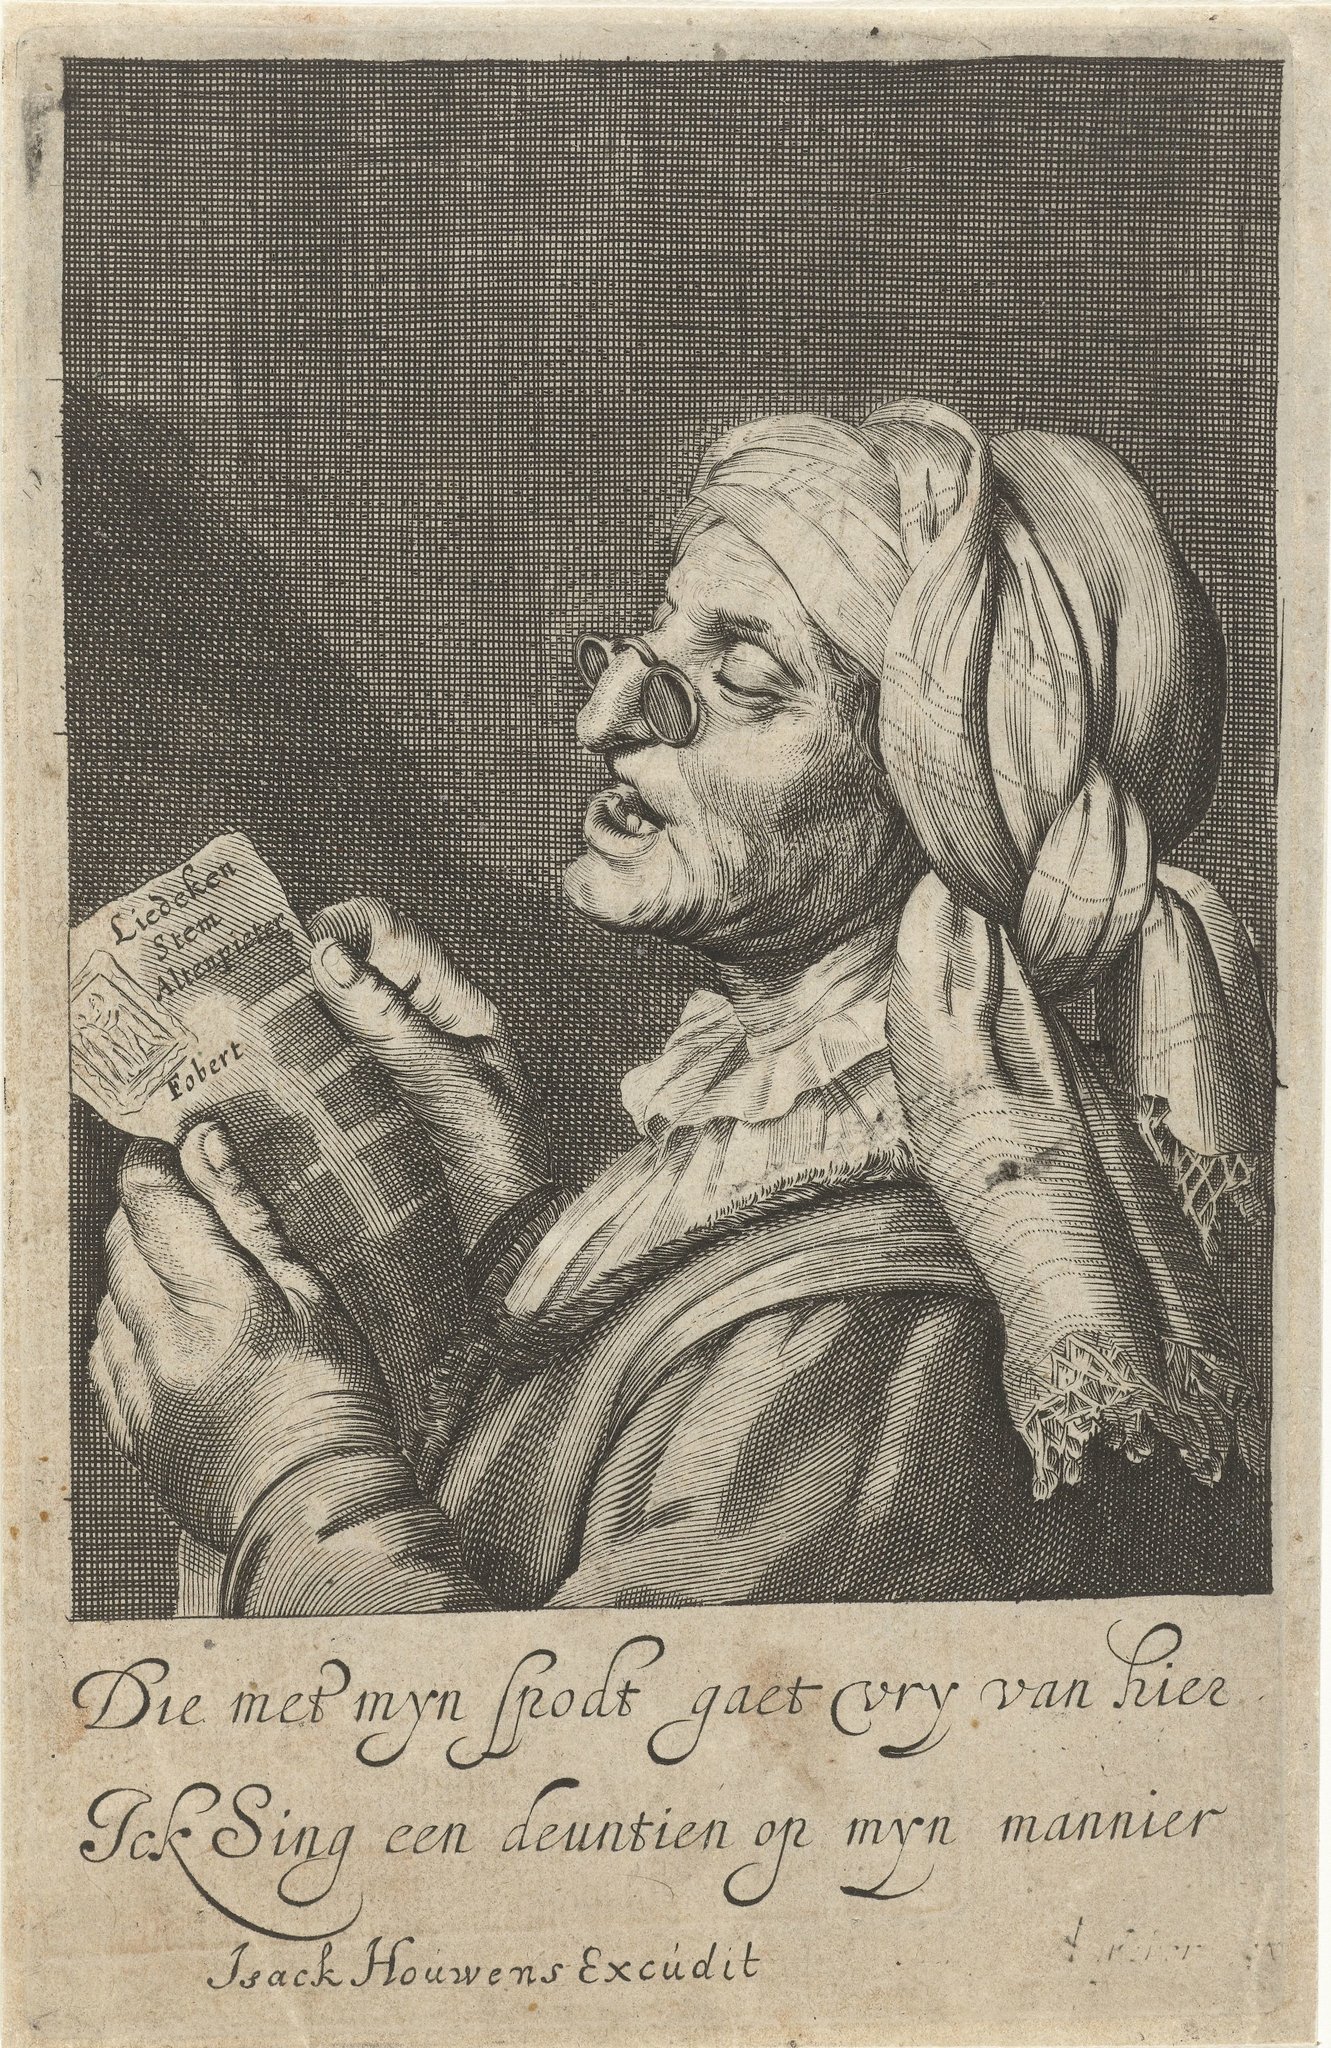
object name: print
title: Oude vrouw zingt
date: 1612-1715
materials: paper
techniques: engraving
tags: old woman, vocal music, singing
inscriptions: collector's mark: Lugt 2228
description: Kopie in spiegelbeeld naar prent van Cornelis van Dalen. Prent mogelijk uit onbekende uitgave, zie verso met fragment tekst. In de marge sporen zichtbaar van vorige uitgave met adres van Cornelis Visscher.